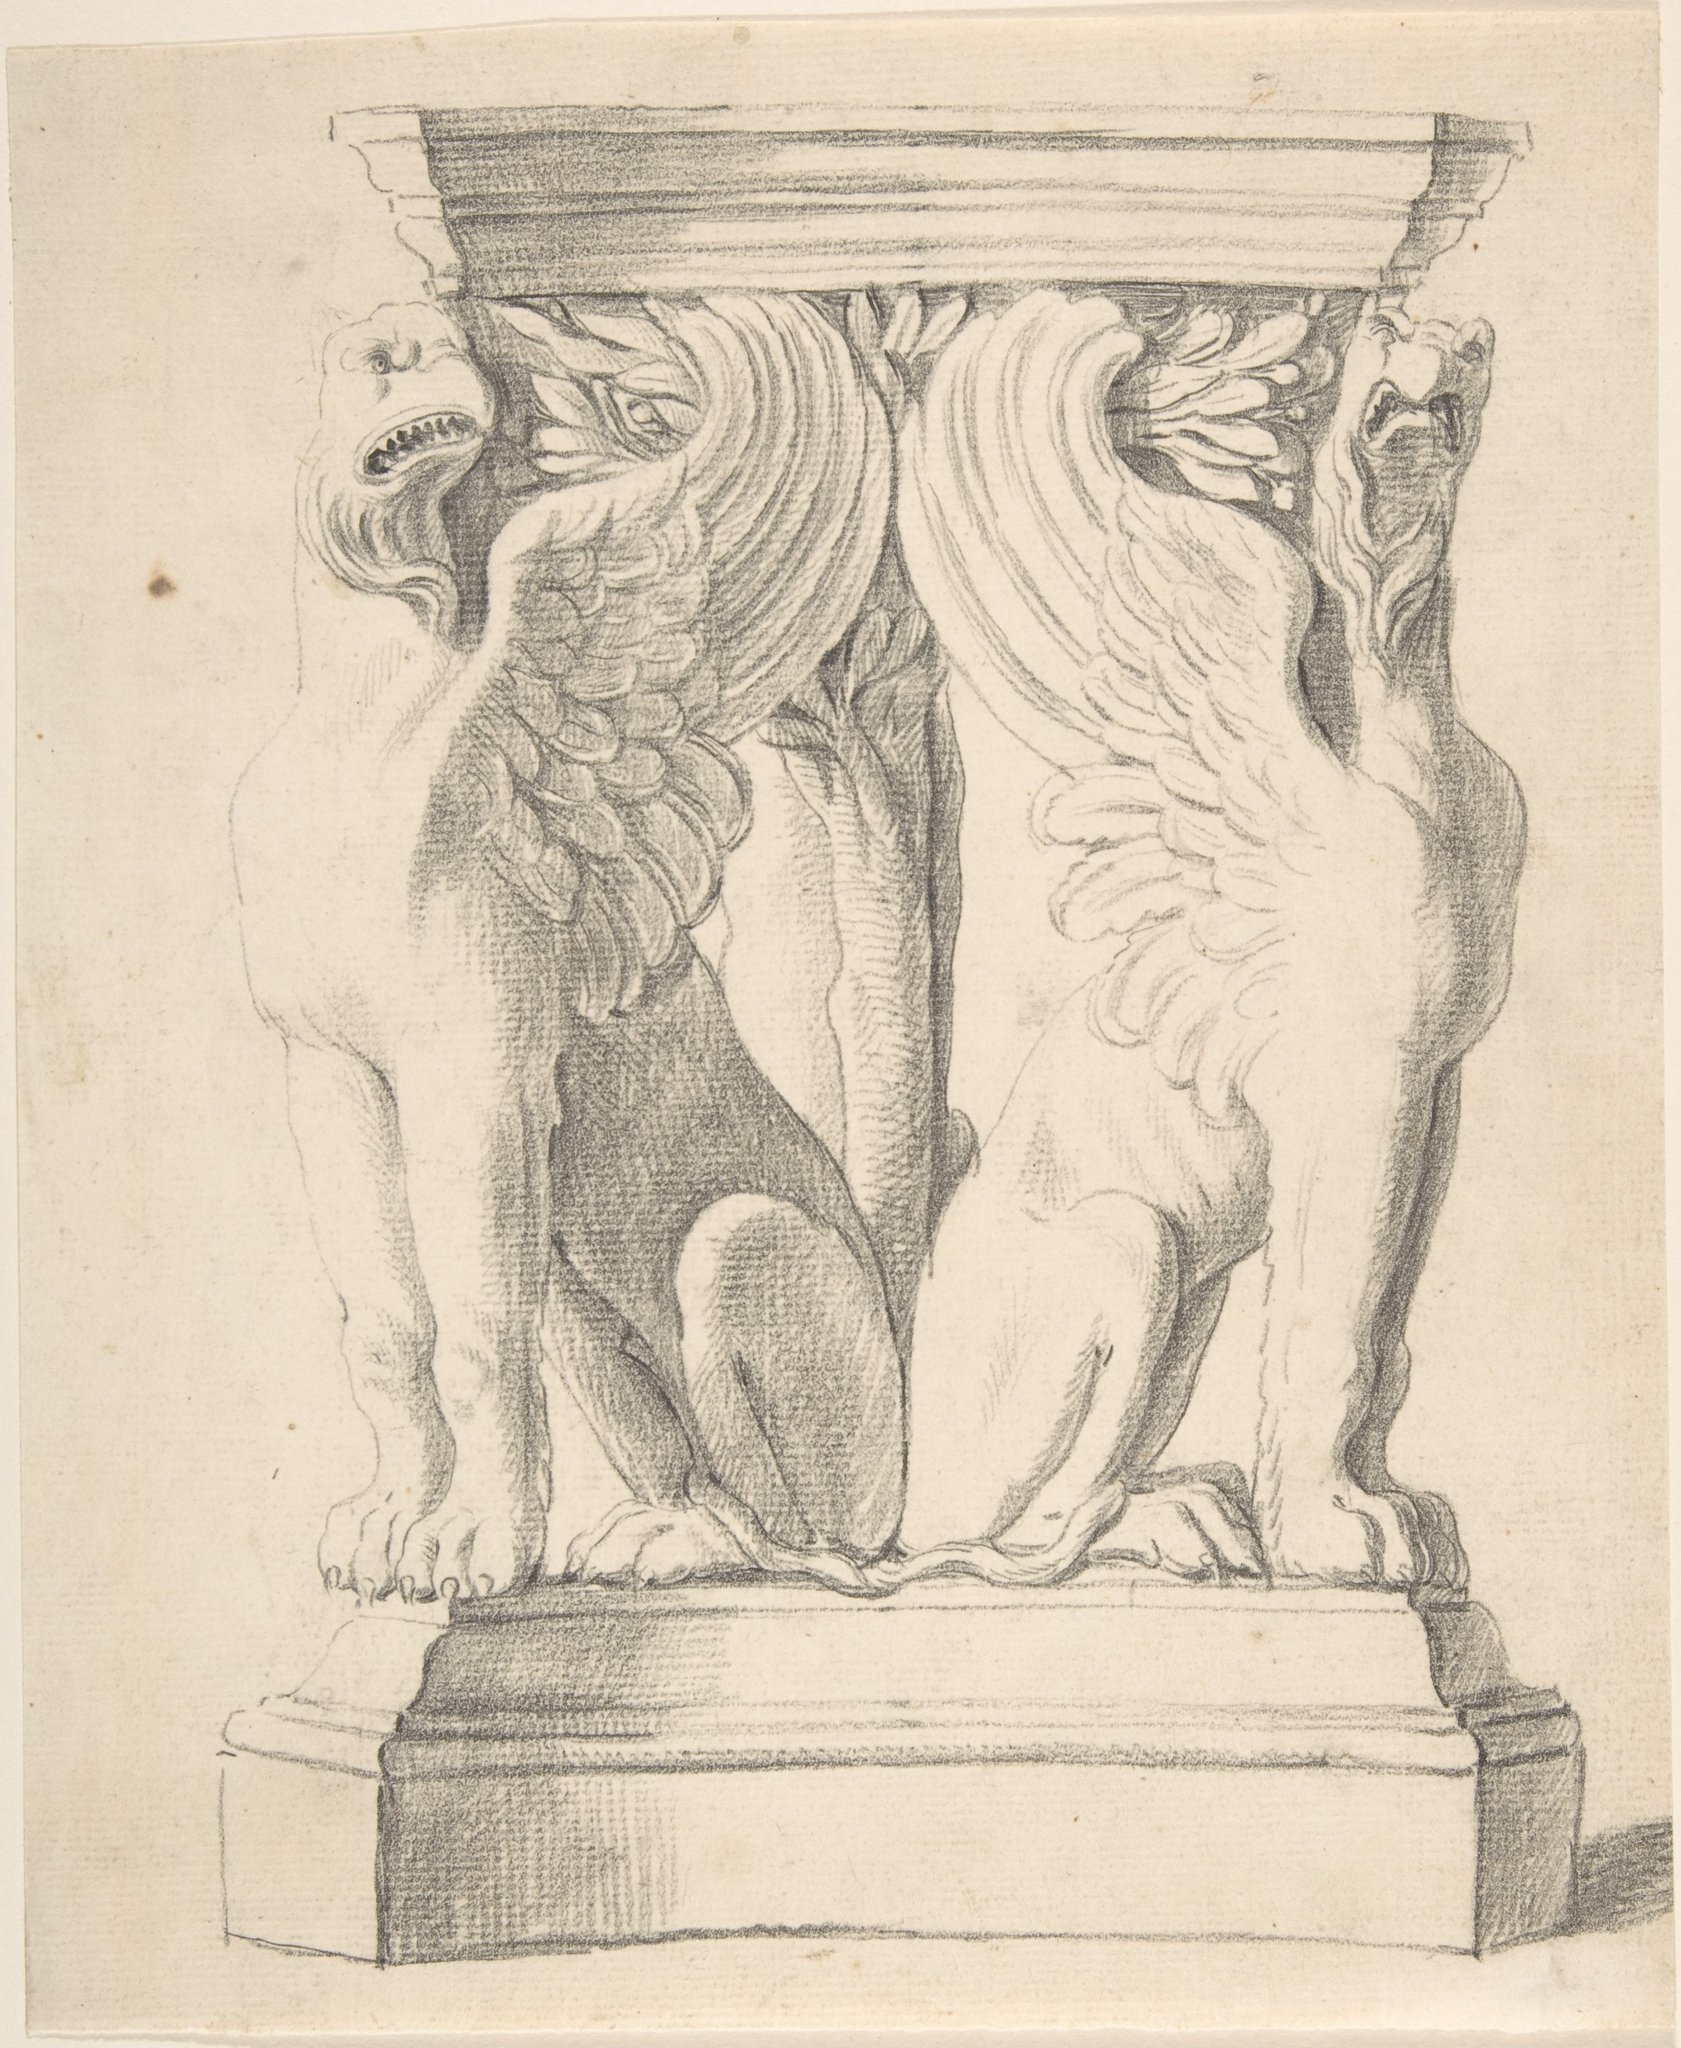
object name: drawing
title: Sketch of a Classical Pedestal with Griffins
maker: thomas hardwick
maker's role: artist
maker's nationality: british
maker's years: 1752-1829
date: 1776-1779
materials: graphite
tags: griffins